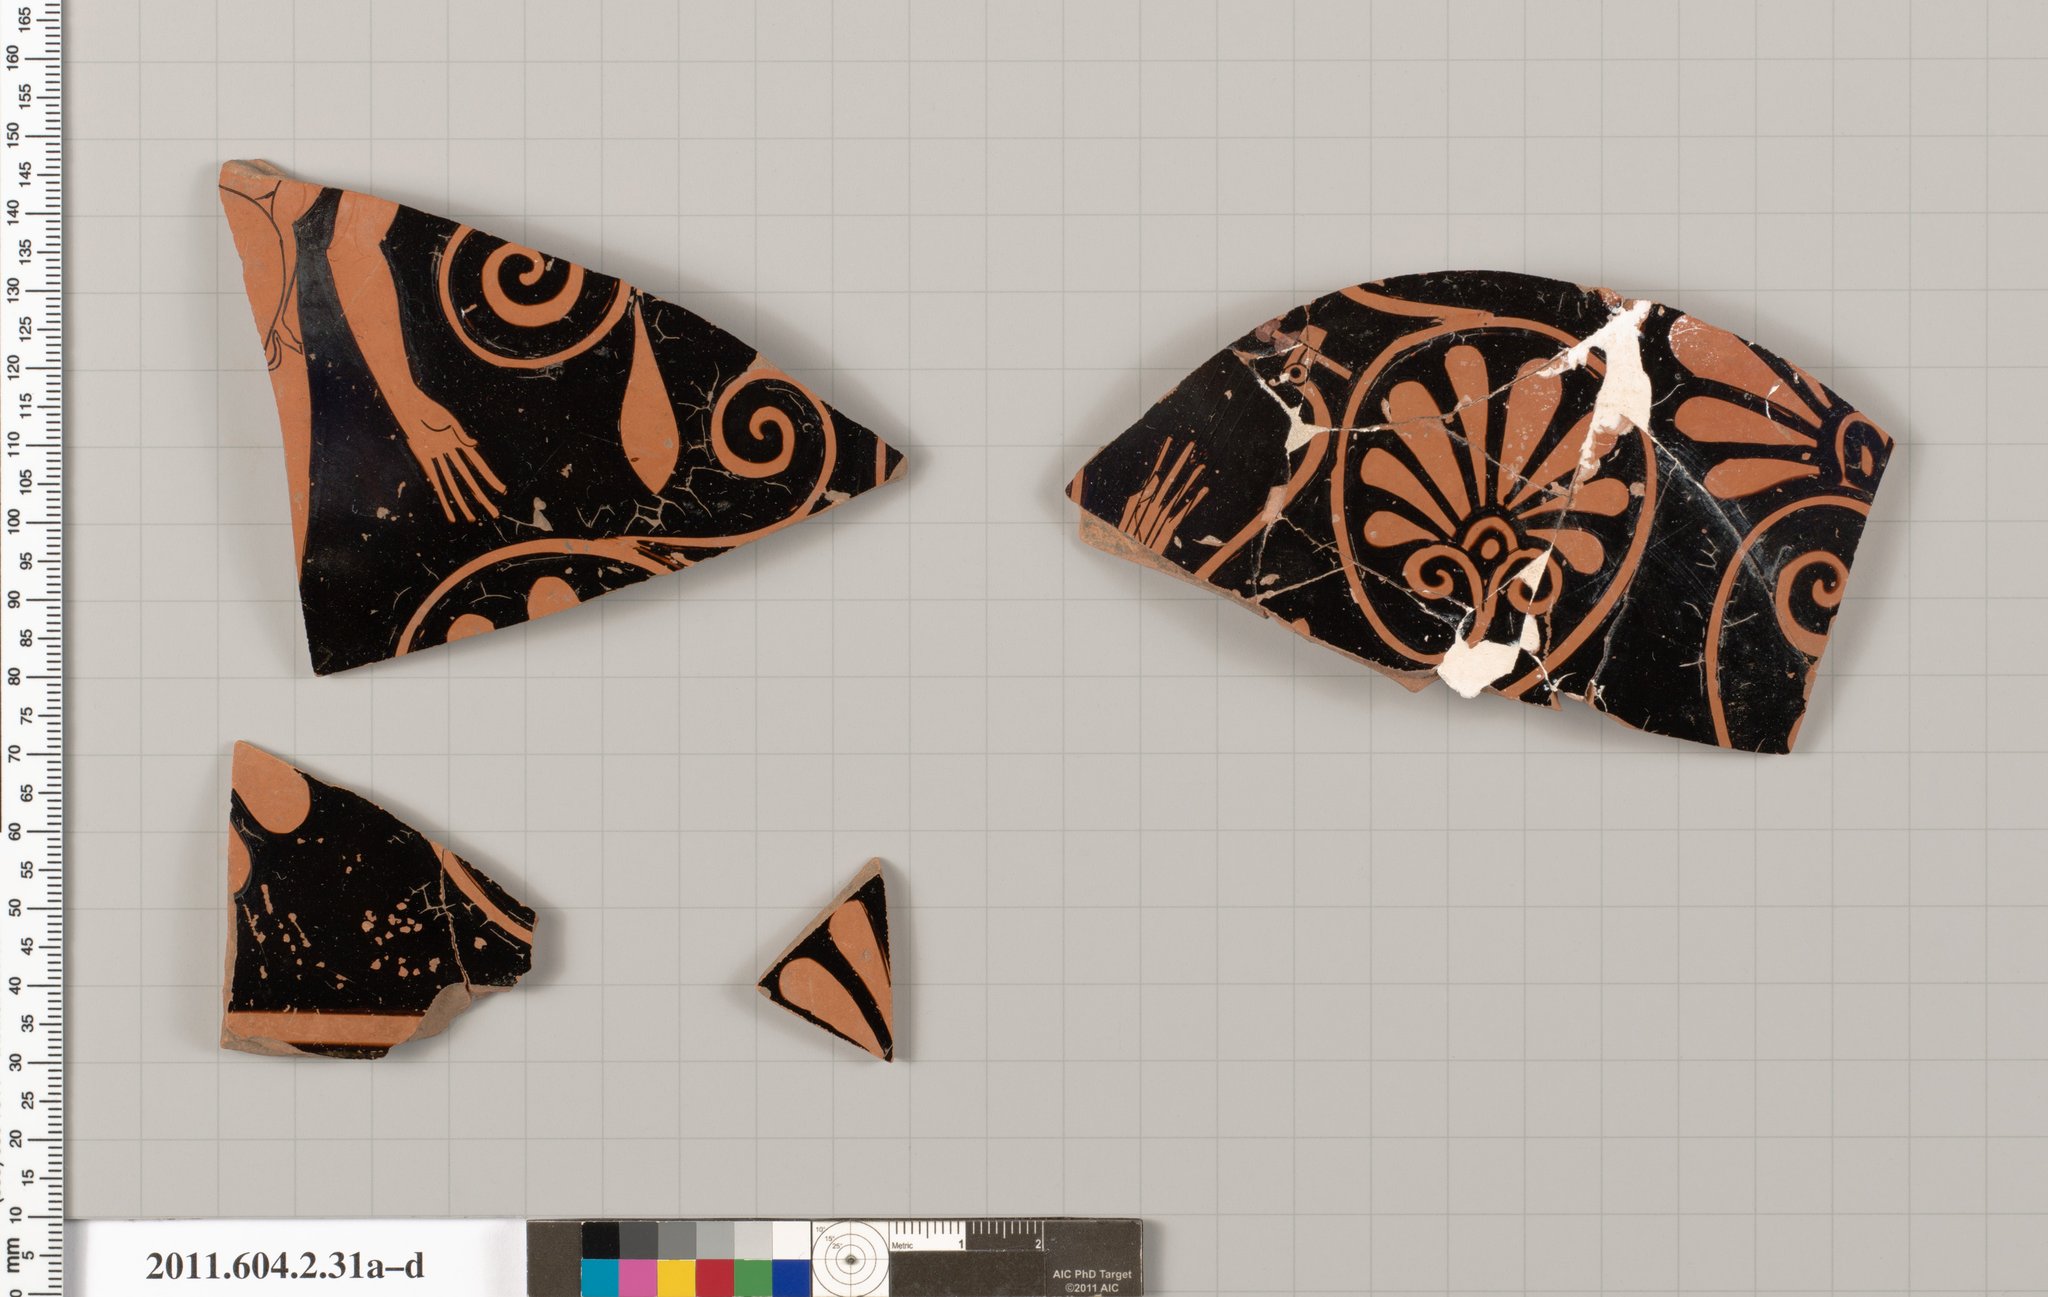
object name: psykter fragment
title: Terracotta fragments of a psykter (vase for cooling wine)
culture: greek, attic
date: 520-500 BCE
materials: terracotta